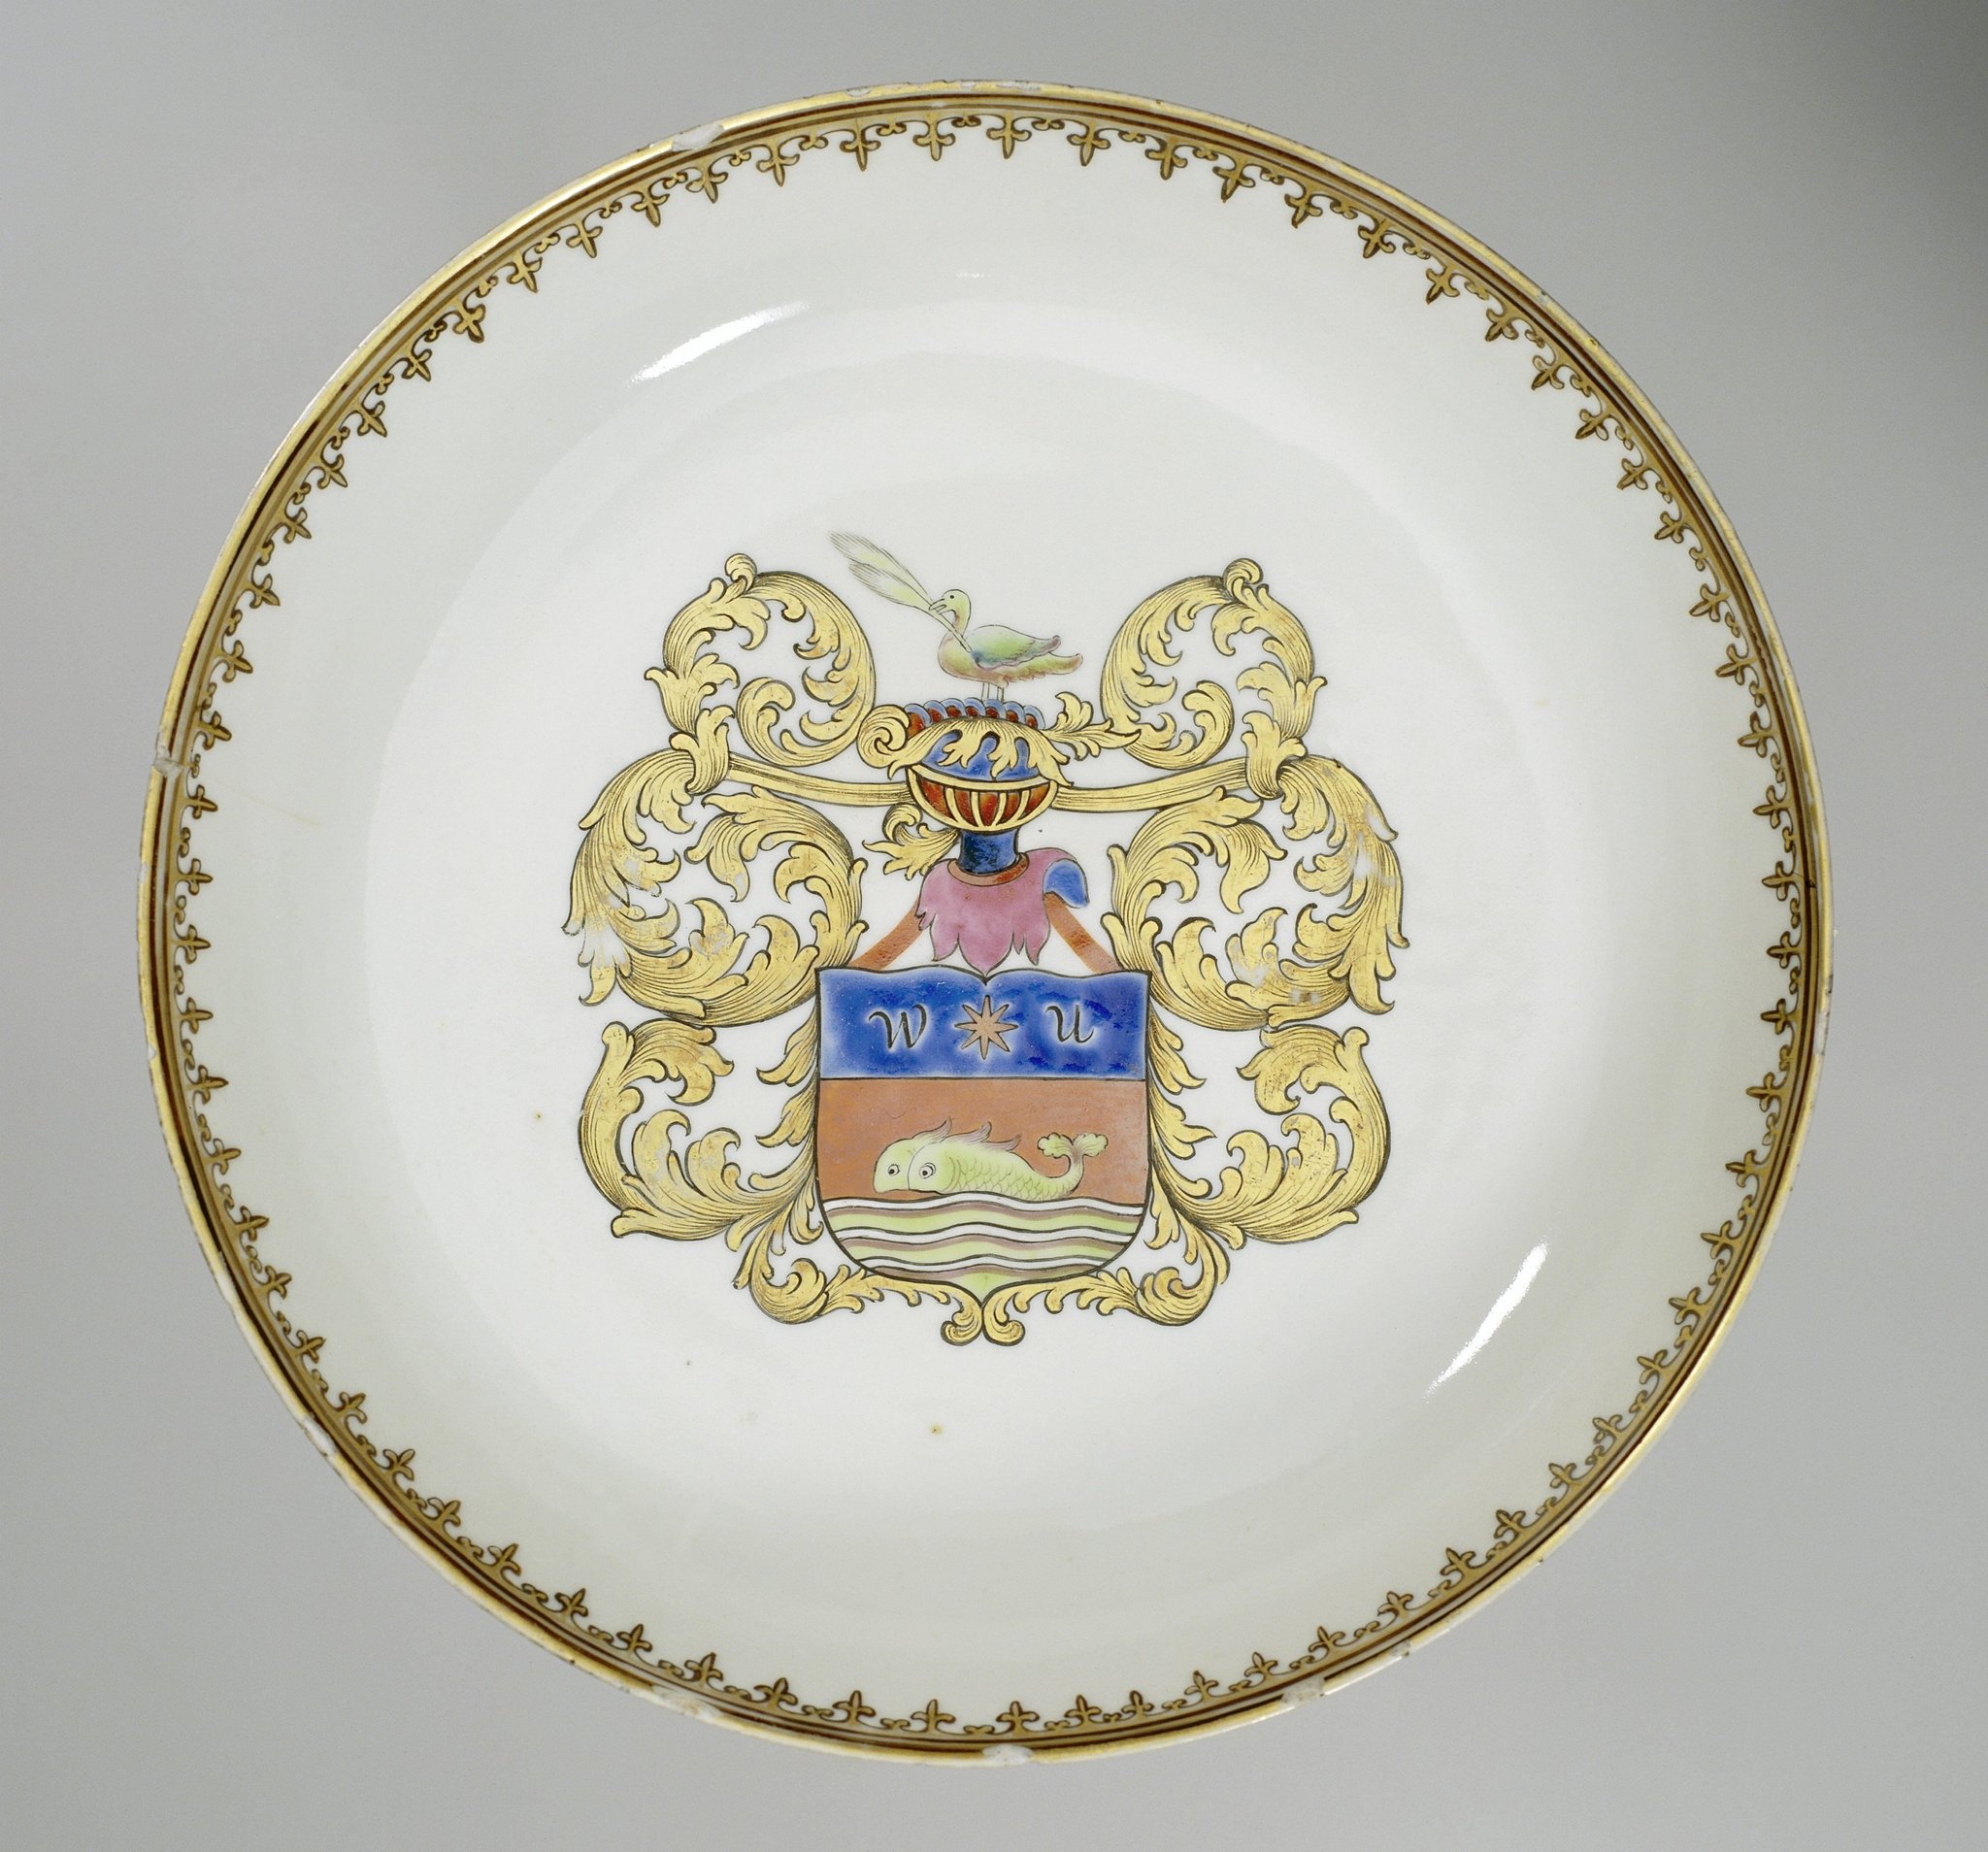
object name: dish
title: Saucer-dish with the arms of the Udemans family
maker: Anonymous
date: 1750-1774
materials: glaze, gold, paint, porcelain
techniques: firing, gilding, turning, vitrification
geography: china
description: Schaal van porselein, beschilderd op het glazuur in blauw, rood, roze, groen, zwart en goud. Op het plat het wapen van de familie Udemans. Het wapen is verdeeld in twee delen: 1. op een rode achtergrond twee vissen of dolfijnen in goud, zwemmend in water, 2. op een blauwe achtergrond de letters ‘W’ en ‘U’ in zwart en in het midden een gouden ster. Het helmteken is een duif en het dekkleed bestaat uit bladranken in goud. Op de rand een spearhead-border. Een barst en enkele chips in de rand. Wapenporselein met emailkleuren.